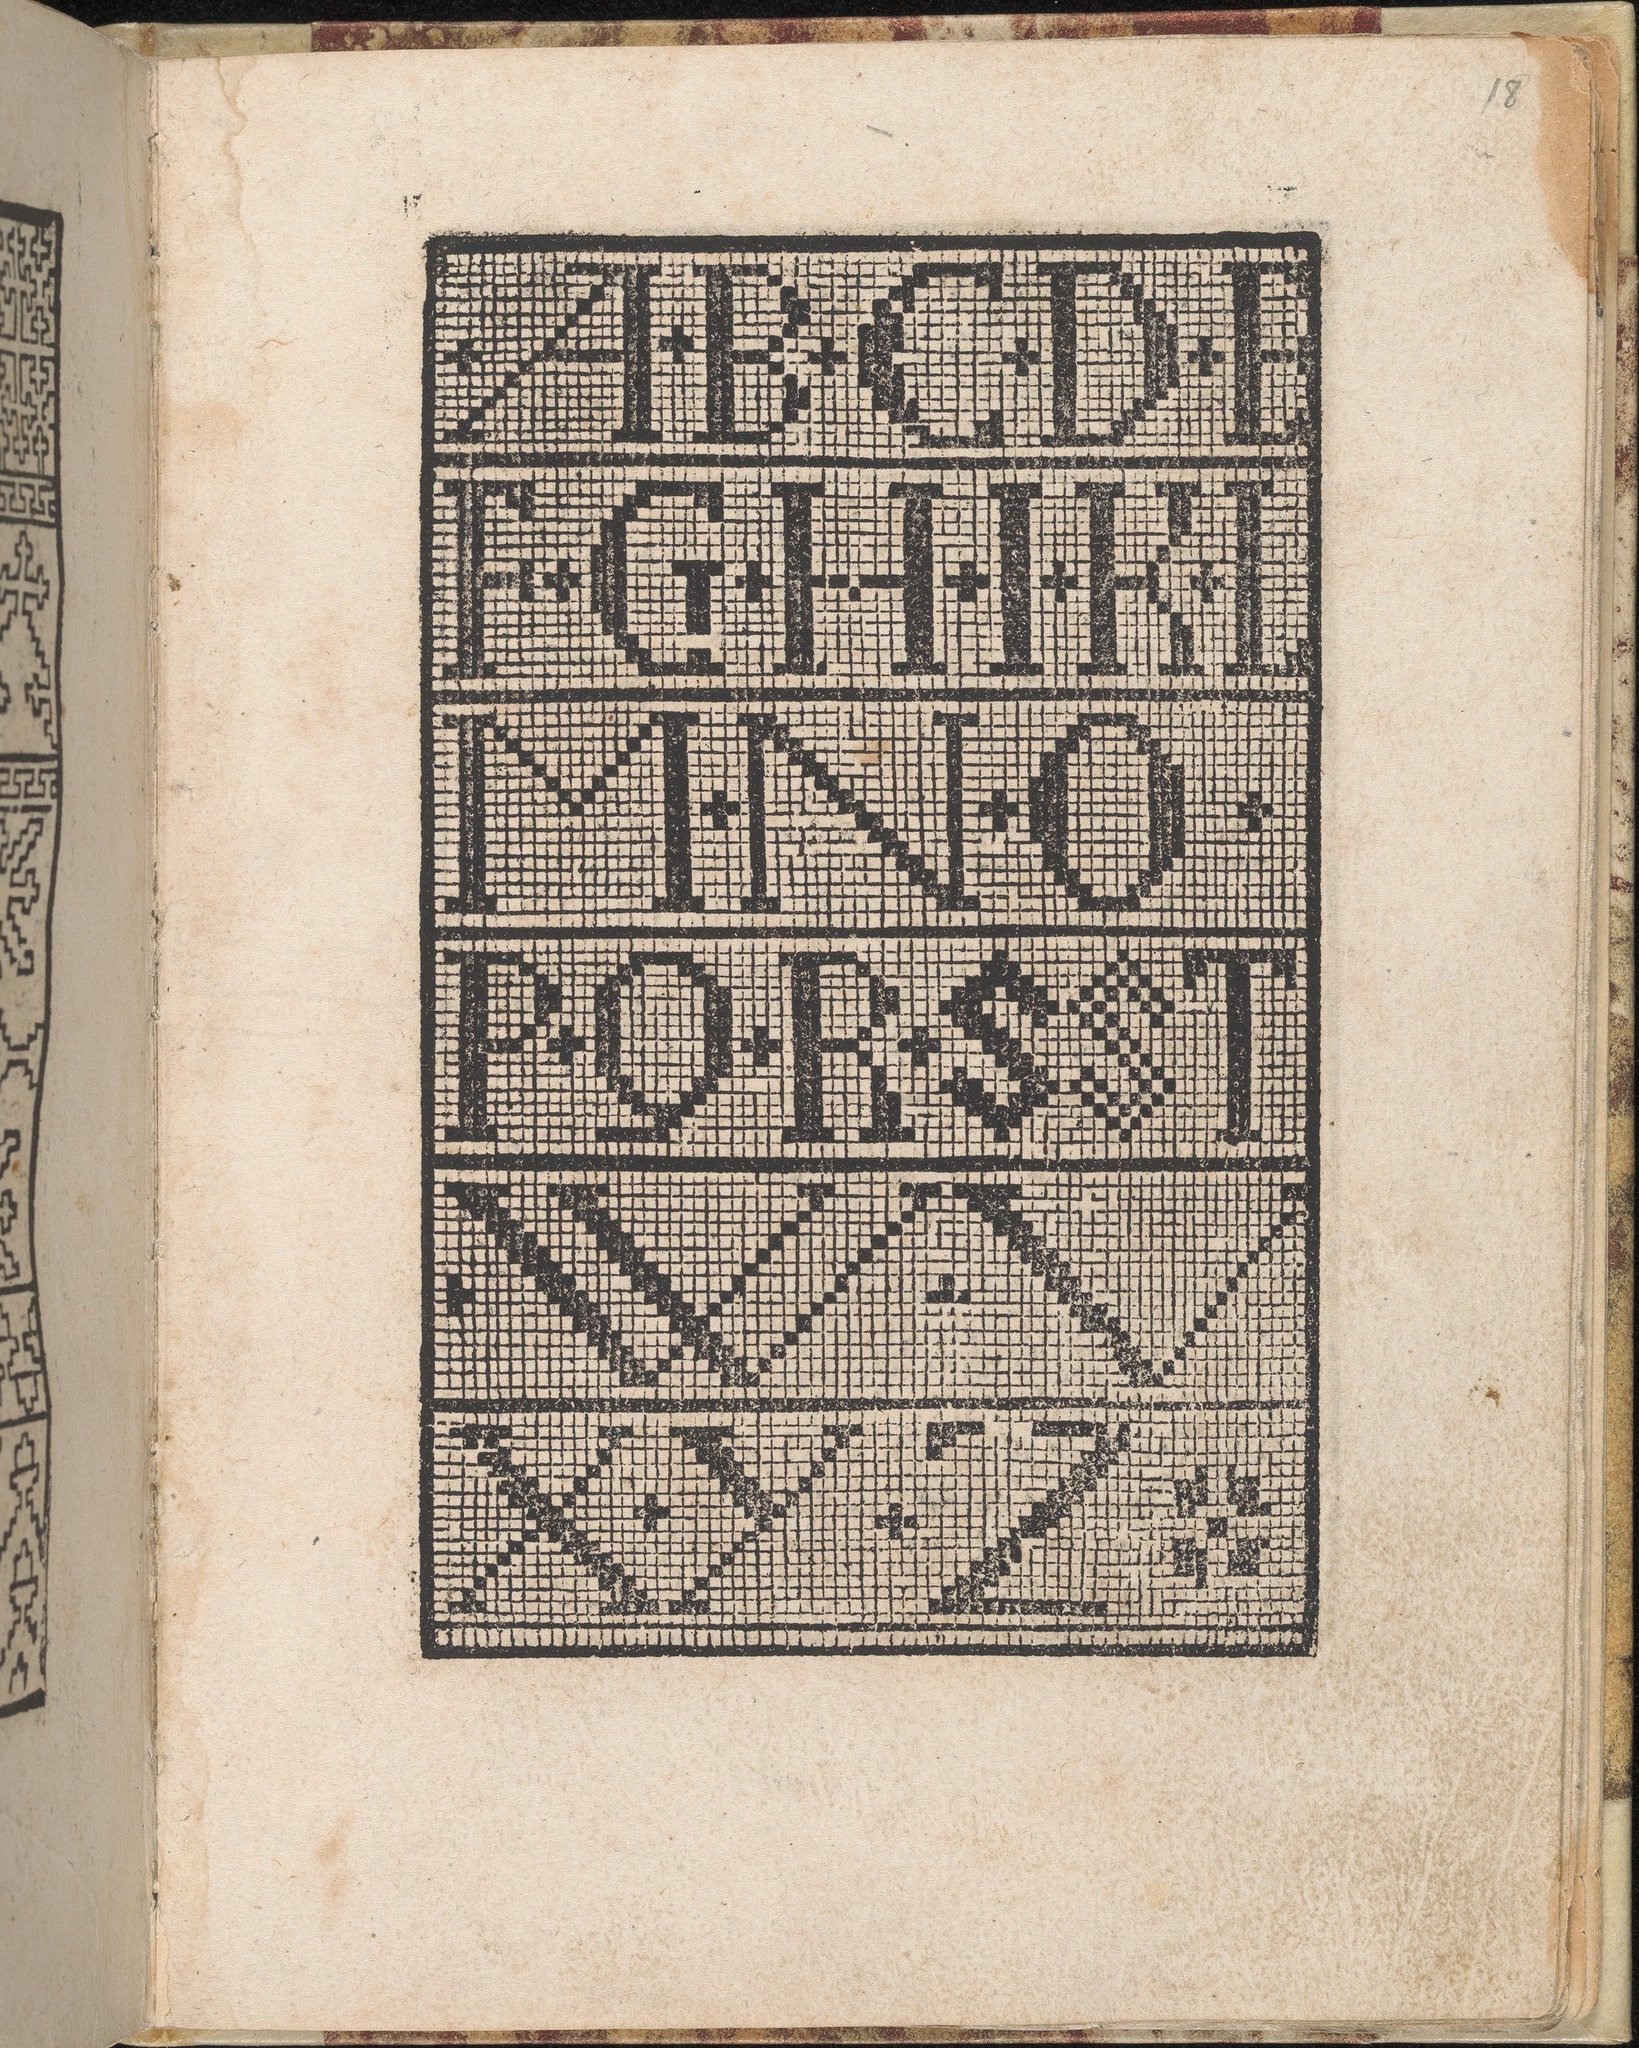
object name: book print ornament architecture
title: Ein new getruckt model Büchli...Page 17, verso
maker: johann schönsperger the younger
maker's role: publisher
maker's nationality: german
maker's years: 1490-1550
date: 1529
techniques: woodcut